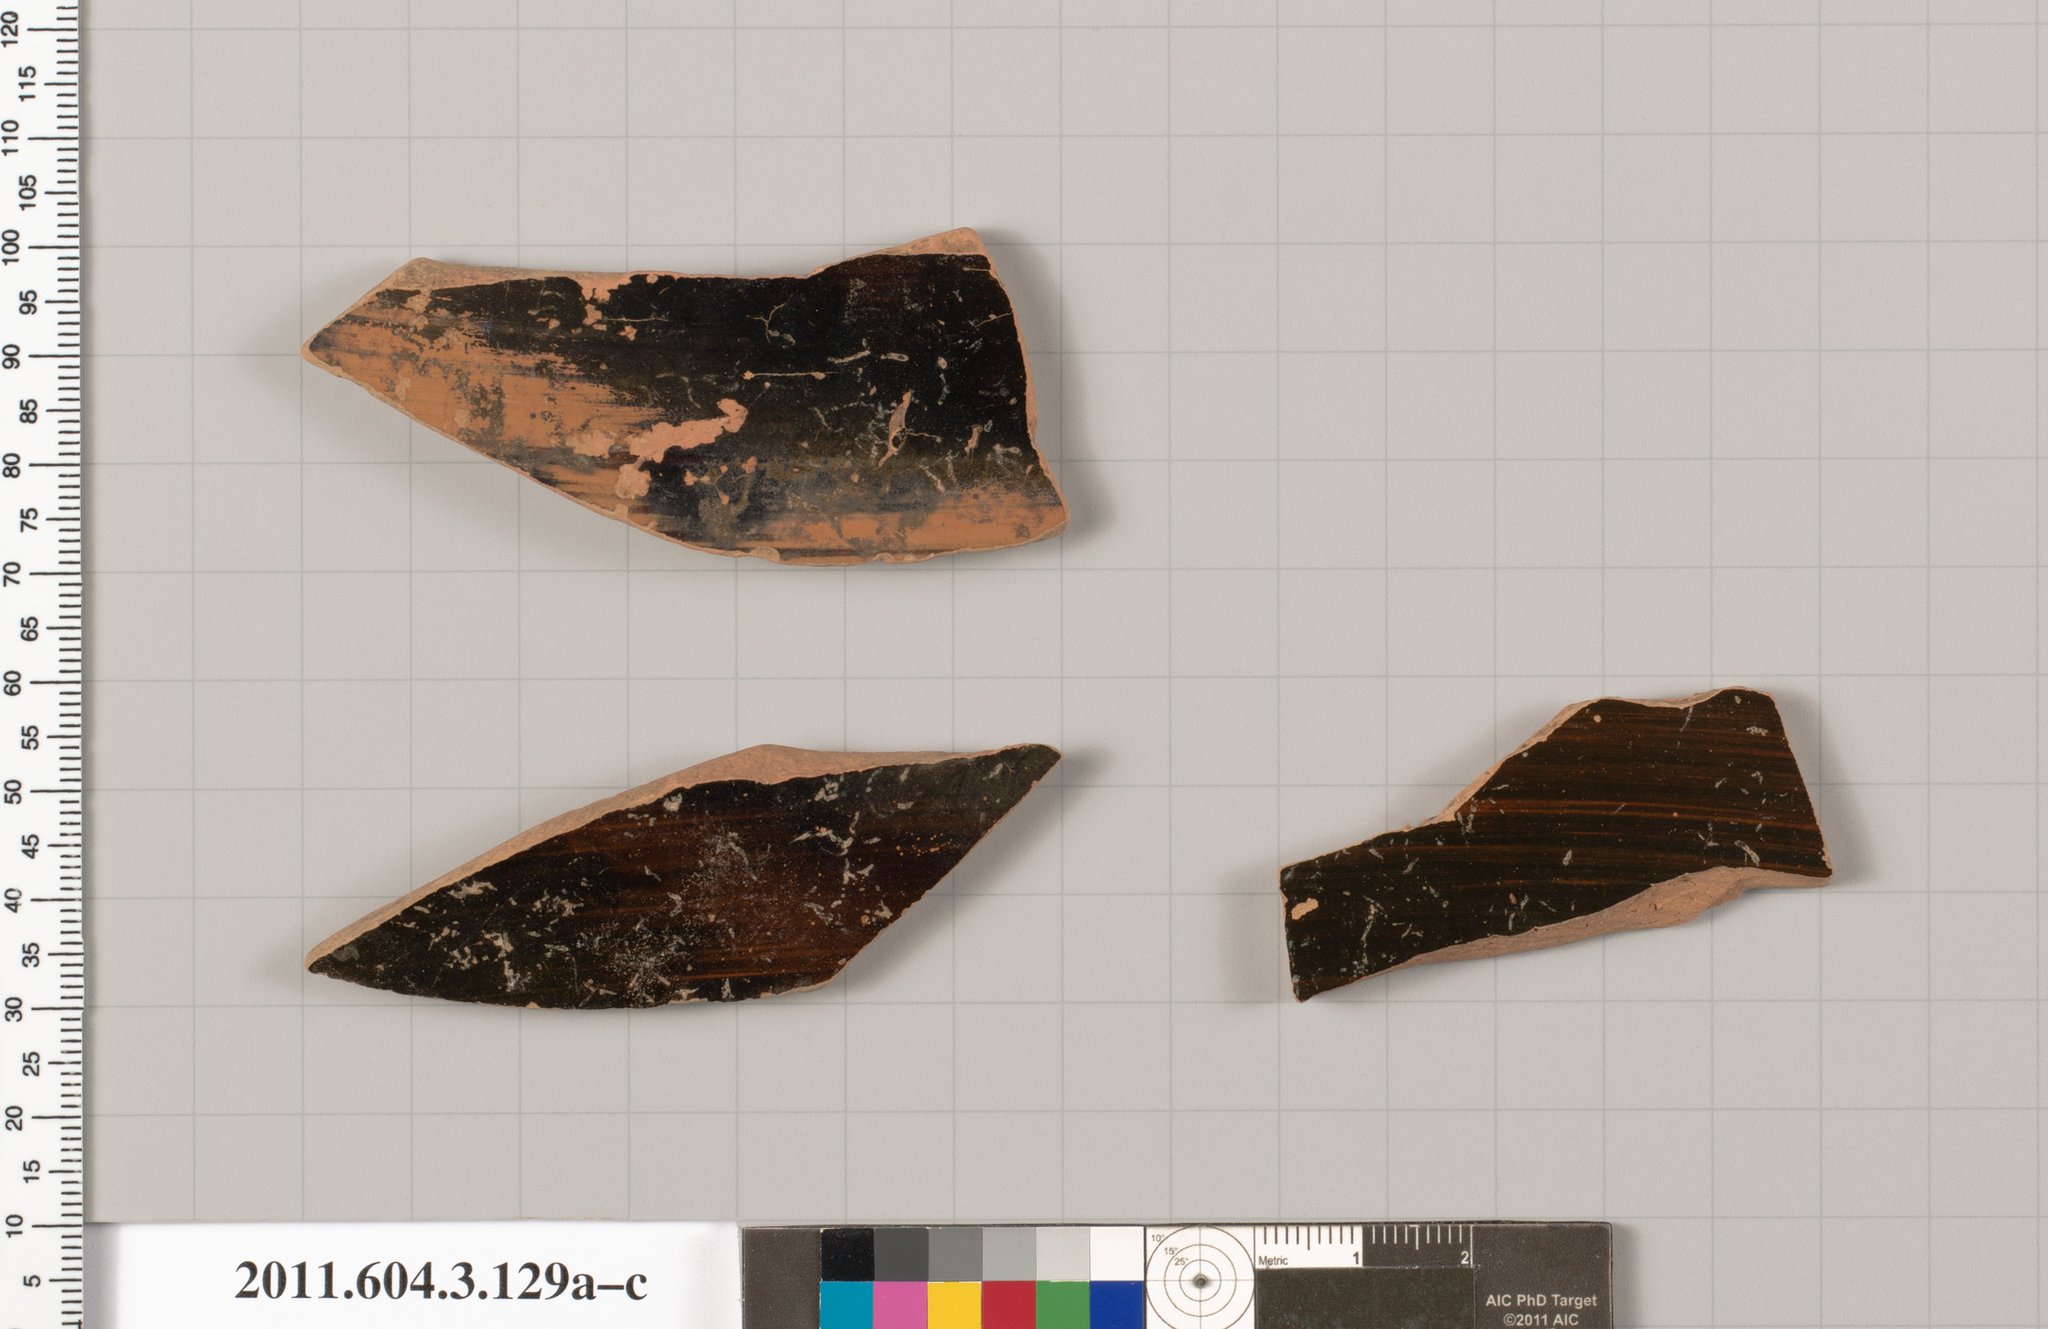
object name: amphora fragment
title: Terracotta fragments of amphorae (jars)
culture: greek, attic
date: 600-468 BCE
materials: terracotta